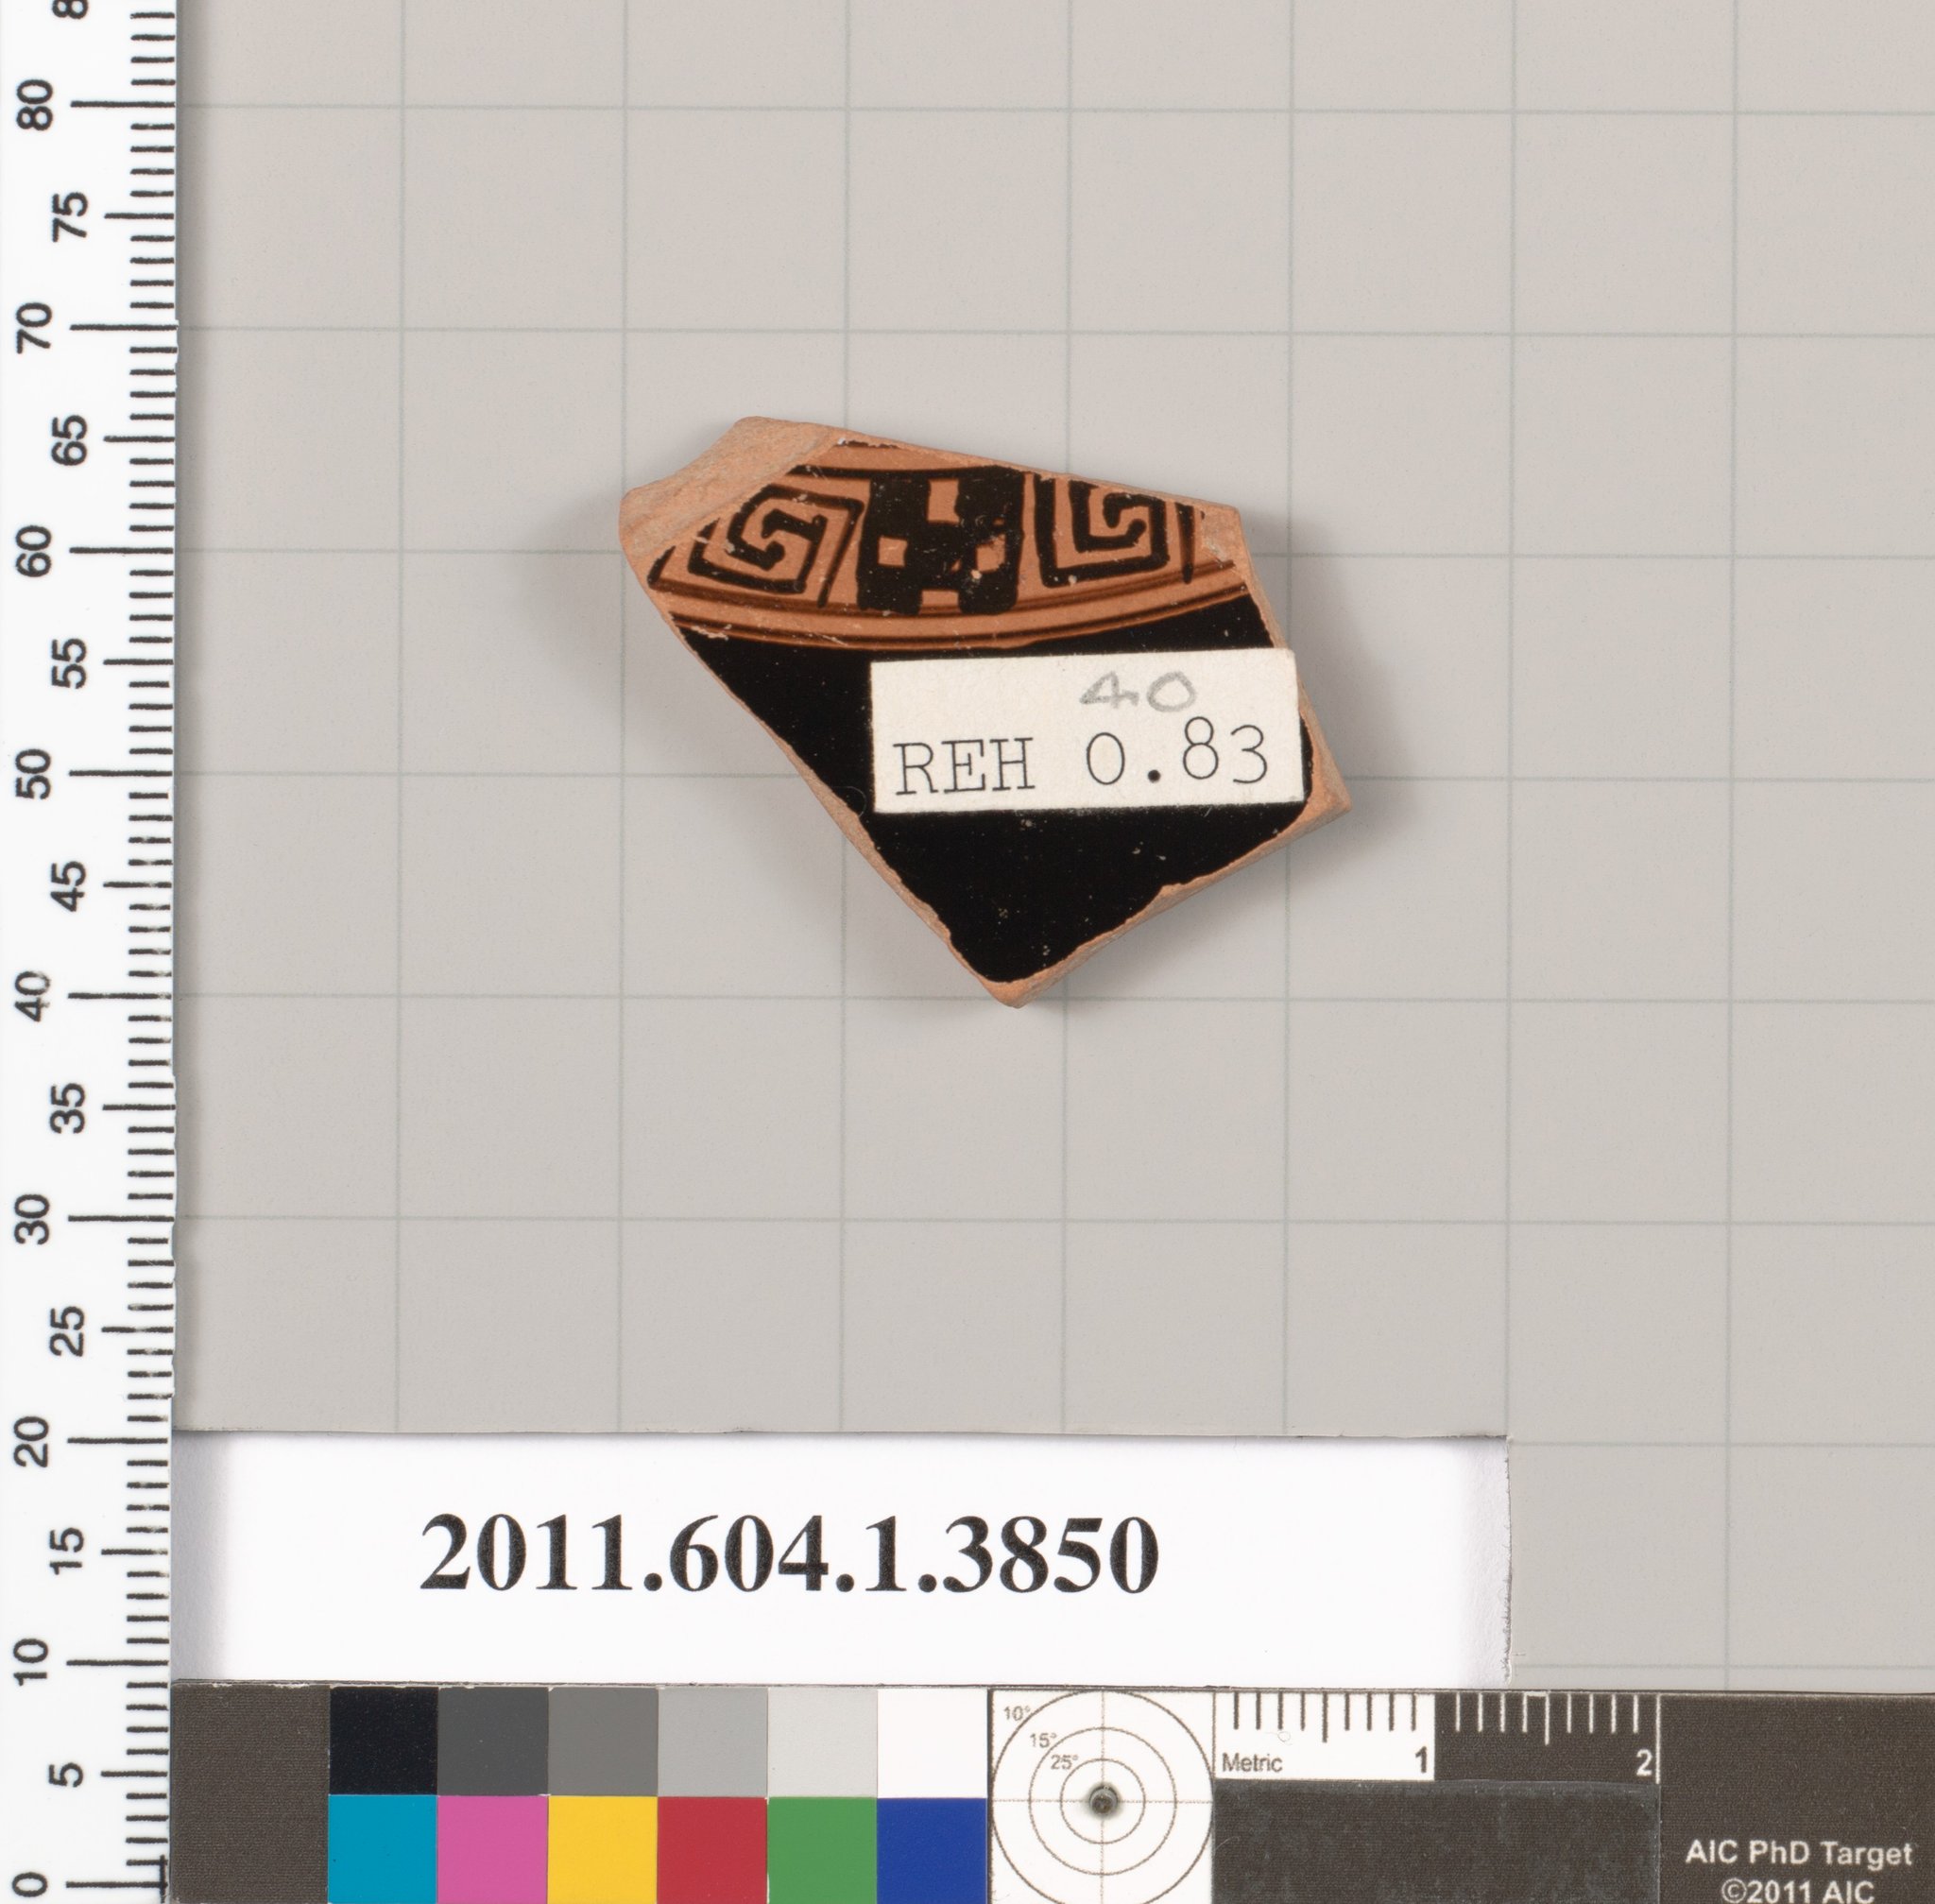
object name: kylix fragment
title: Terracotta fragment of a kylix (drinking cup)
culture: greek, attic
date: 475-451 BCE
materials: terracotta